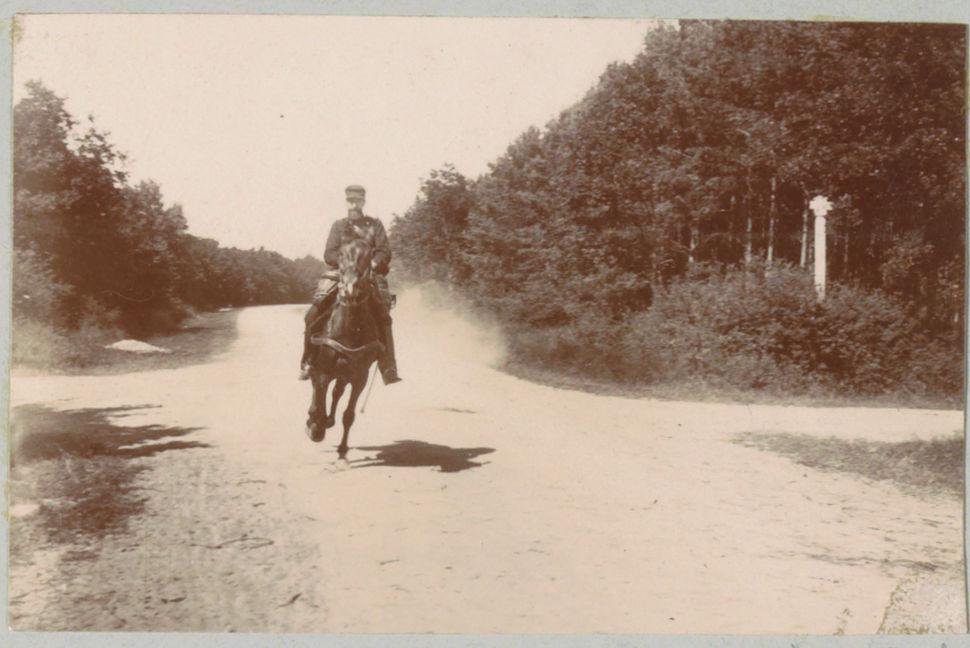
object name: photograph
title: Geüniformeerde man te paard op een bospad, vermoedelijk bij Pontoise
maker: delizy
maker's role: manufacturer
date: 1897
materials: paper, photographic support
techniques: gelatin silver print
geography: pontoise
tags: riding a horse, ass, or mule; rider, horseman, road, path, (military) uniforms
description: Onderdeel van Fotoalbum van een Franse amateurfotograaf met opnames van uitstapjes in Frankrijk, Spanje, België, Luxemburg en Nederland, de eerste automobielen en autoraces.